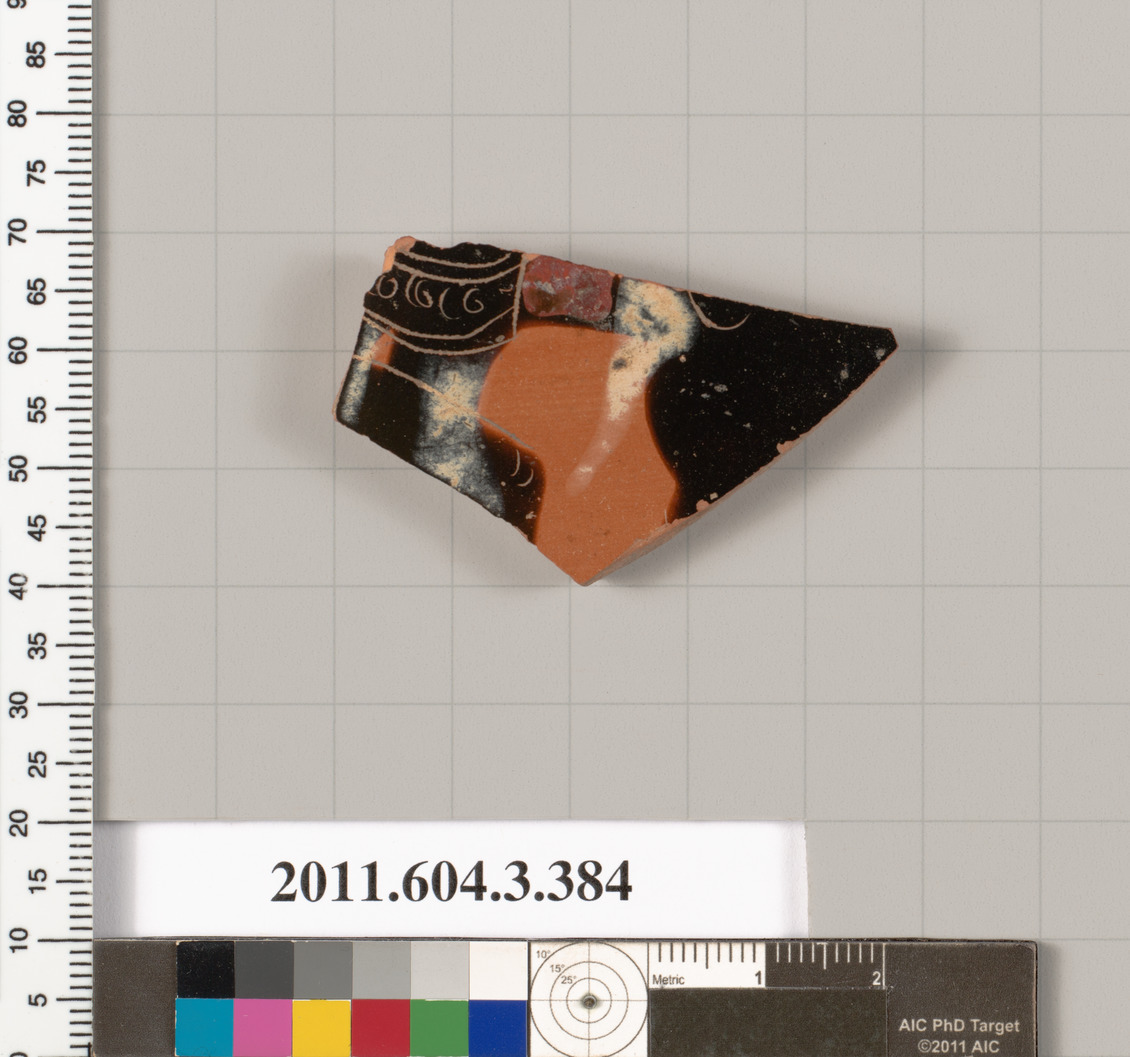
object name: neck amphora fragment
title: Terracotta fragment of a neck-amphora (jar)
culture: greek, attic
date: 520-510 BCE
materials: terracotta